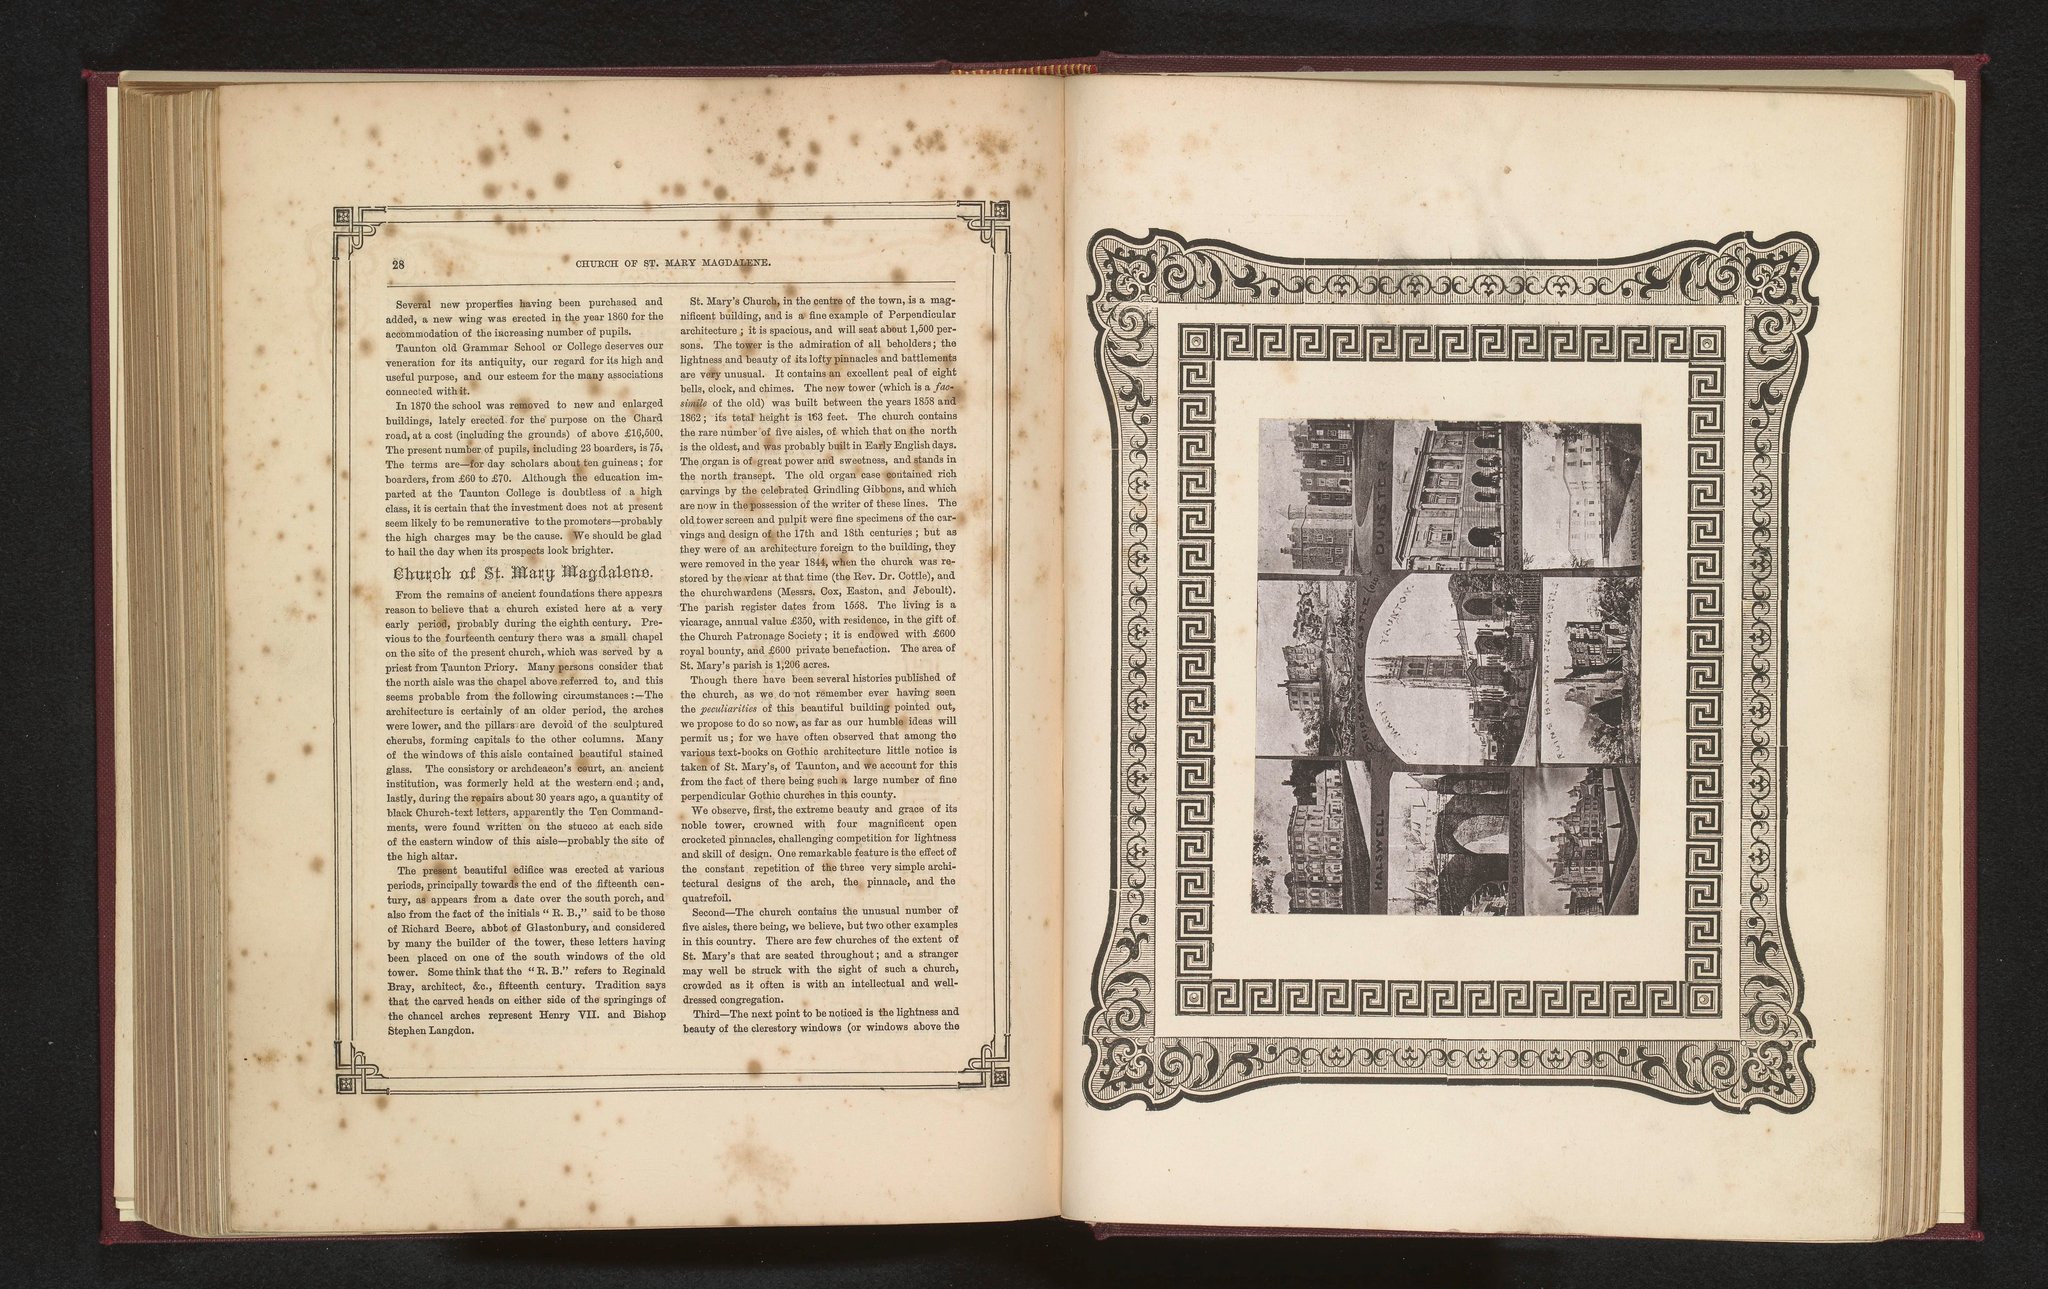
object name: photomechanical print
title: Negen gezichten op gebouwen en ruïnes in West Dorset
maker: Anonymous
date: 1868-1873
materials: paper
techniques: photoaquatint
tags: ruin of a building ~ architecture, church (exterior), exterior ~ representation of a building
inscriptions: inscription: ‘Halswell (...) Heatherton’